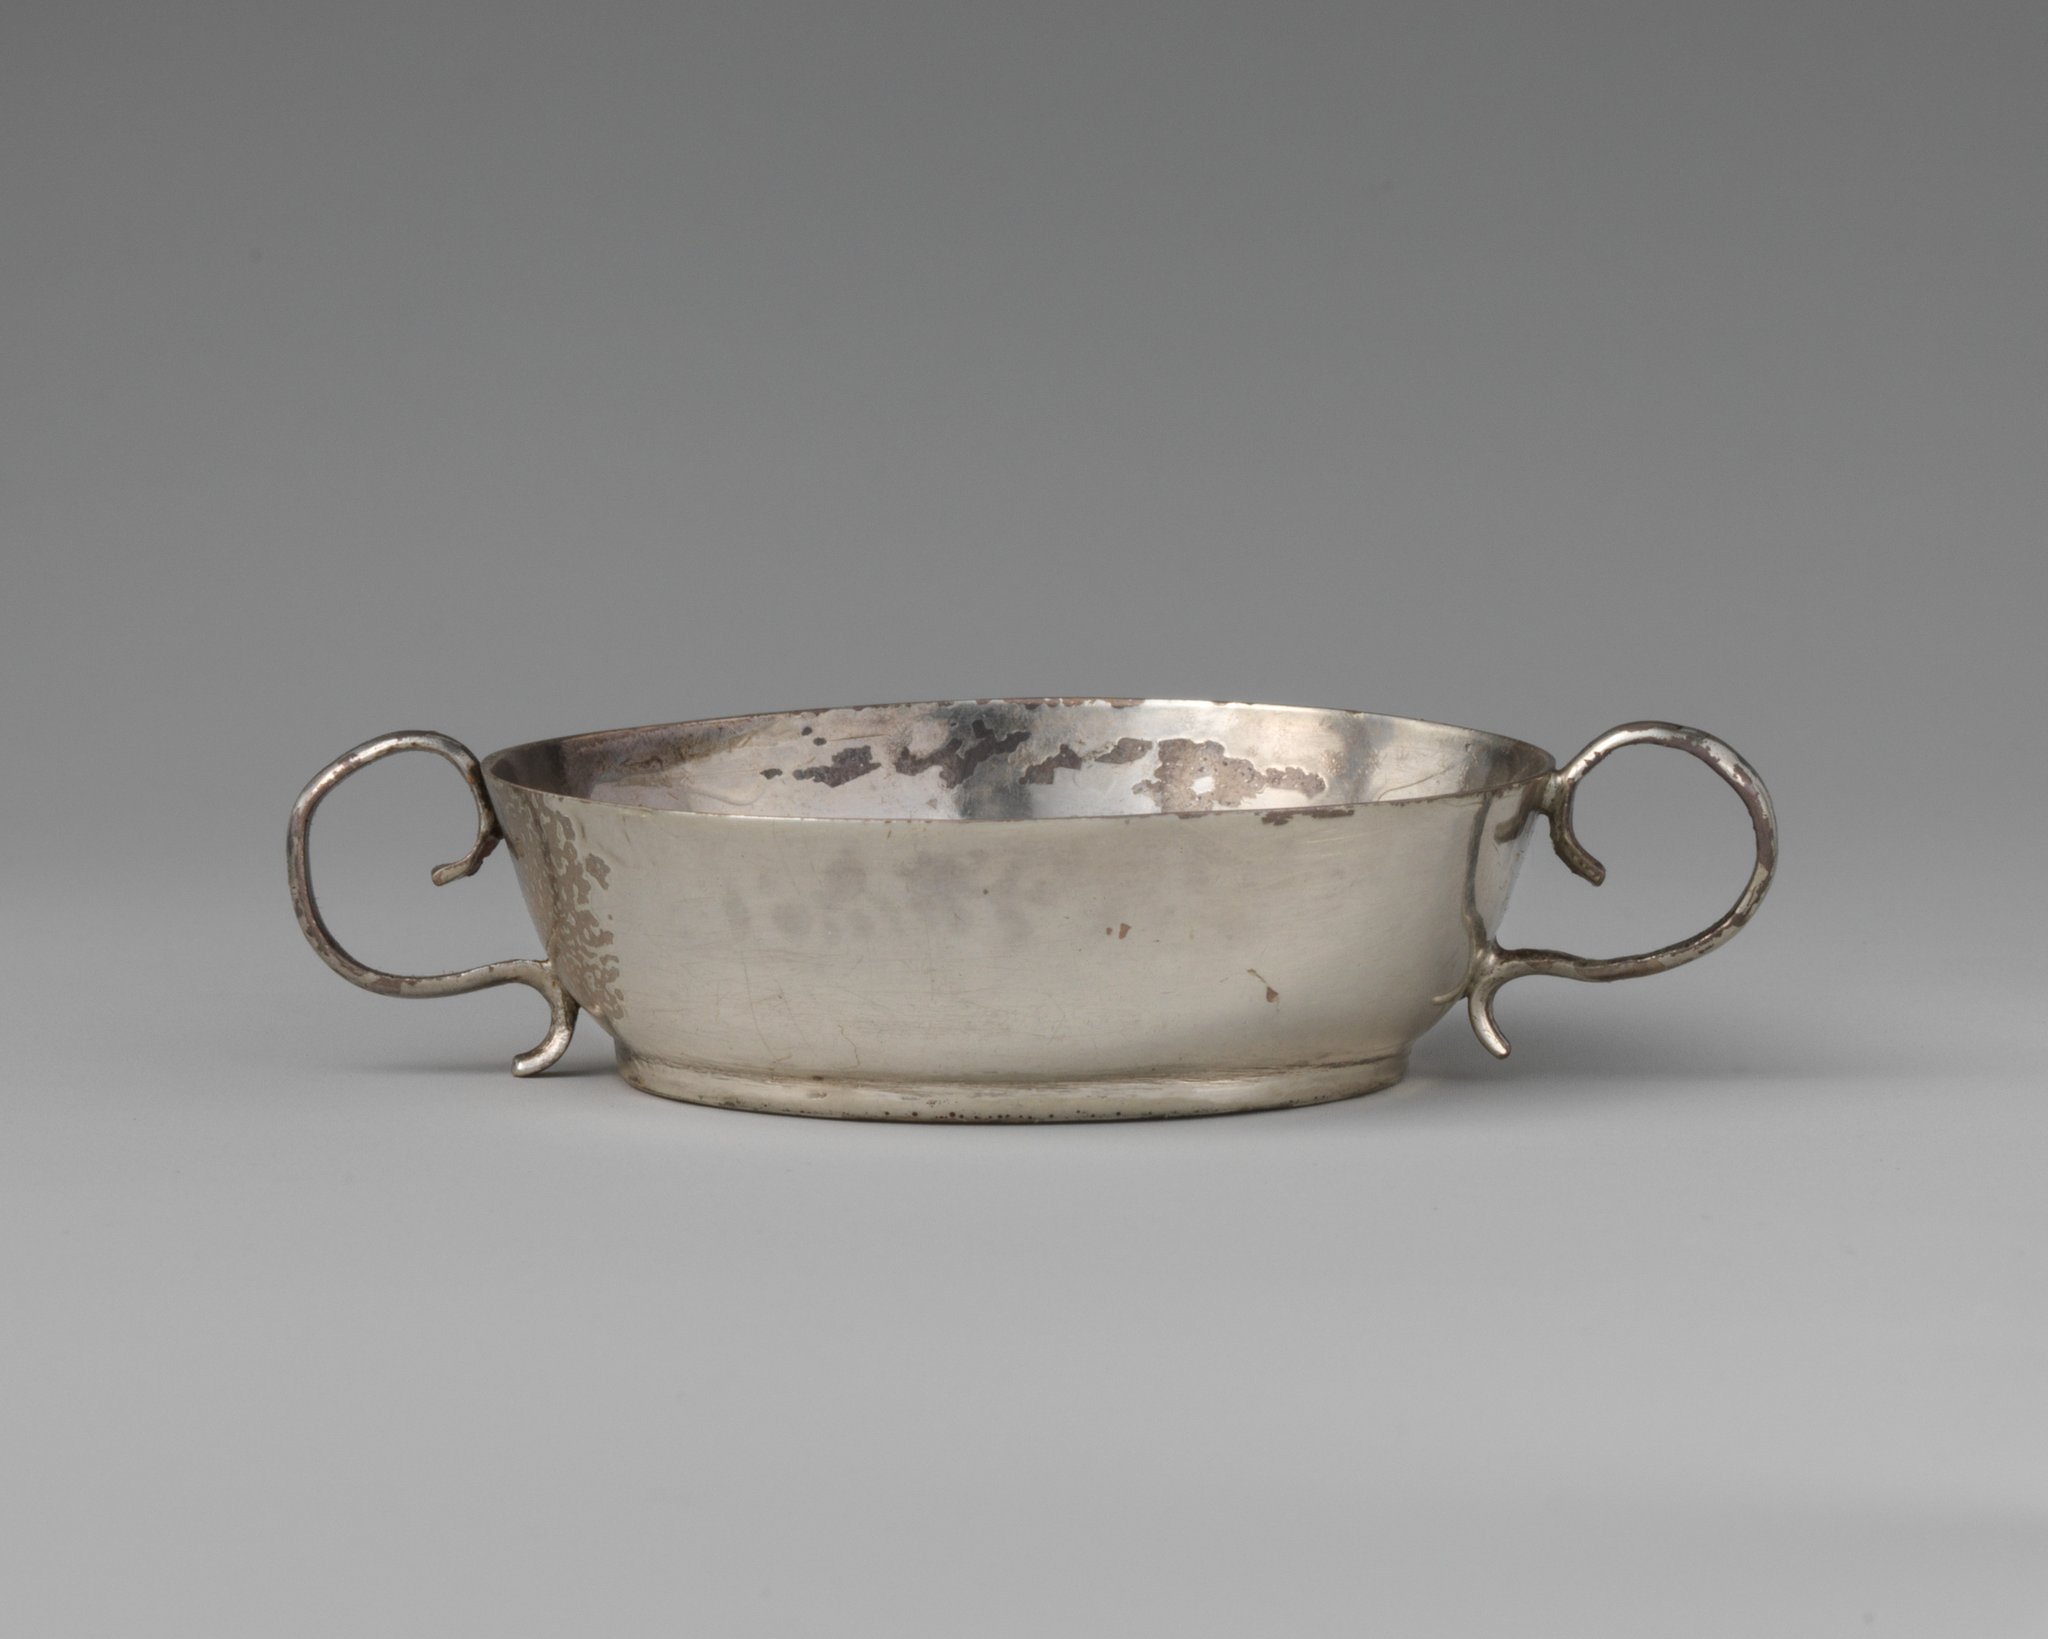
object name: porringer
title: Miniature porringer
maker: thomas waterhouse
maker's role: maker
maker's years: 1702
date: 1702-1703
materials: silver